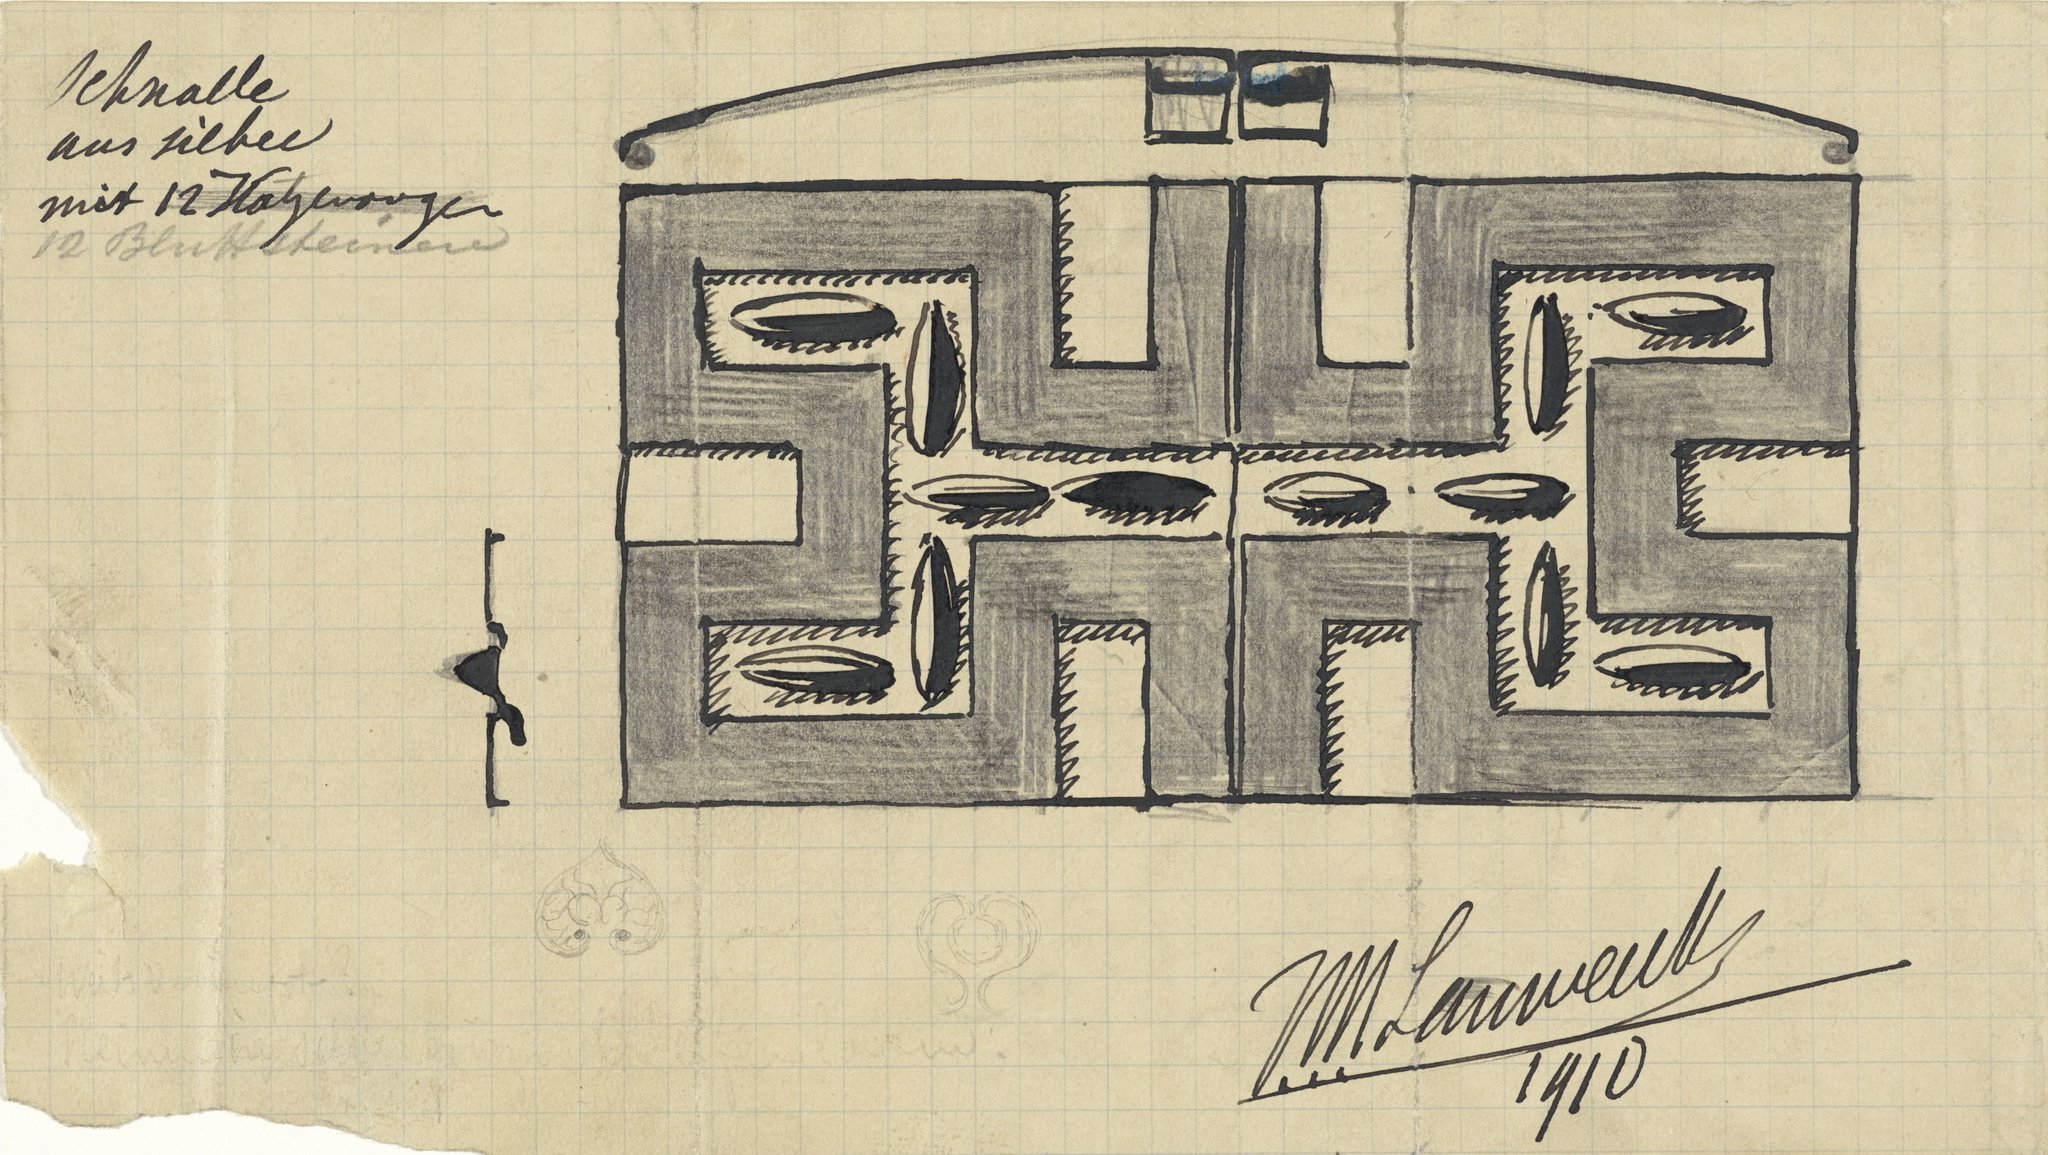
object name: design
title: Ontwerp voor een zilveren gesp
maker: mathieu lauweriks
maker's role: designer, draughtsman, print maker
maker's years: 1864-1932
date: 1910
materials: ink, pencil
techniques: pen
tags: buckle